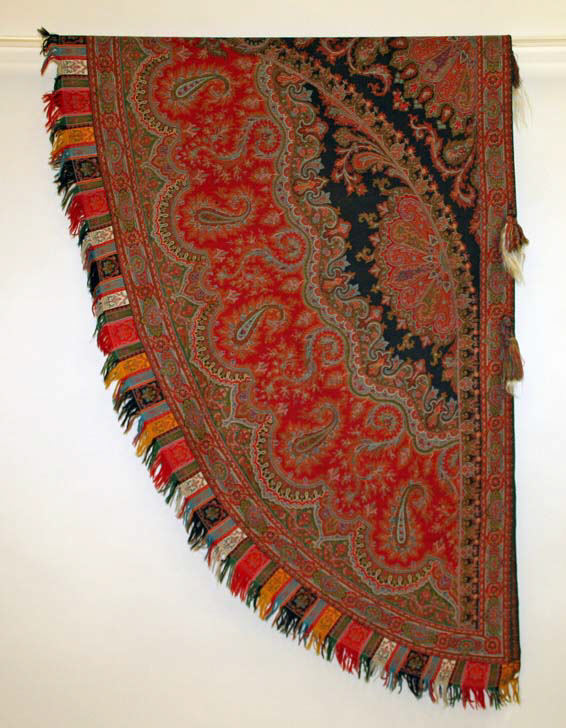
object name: shawl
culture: scottish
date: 1856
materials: wool